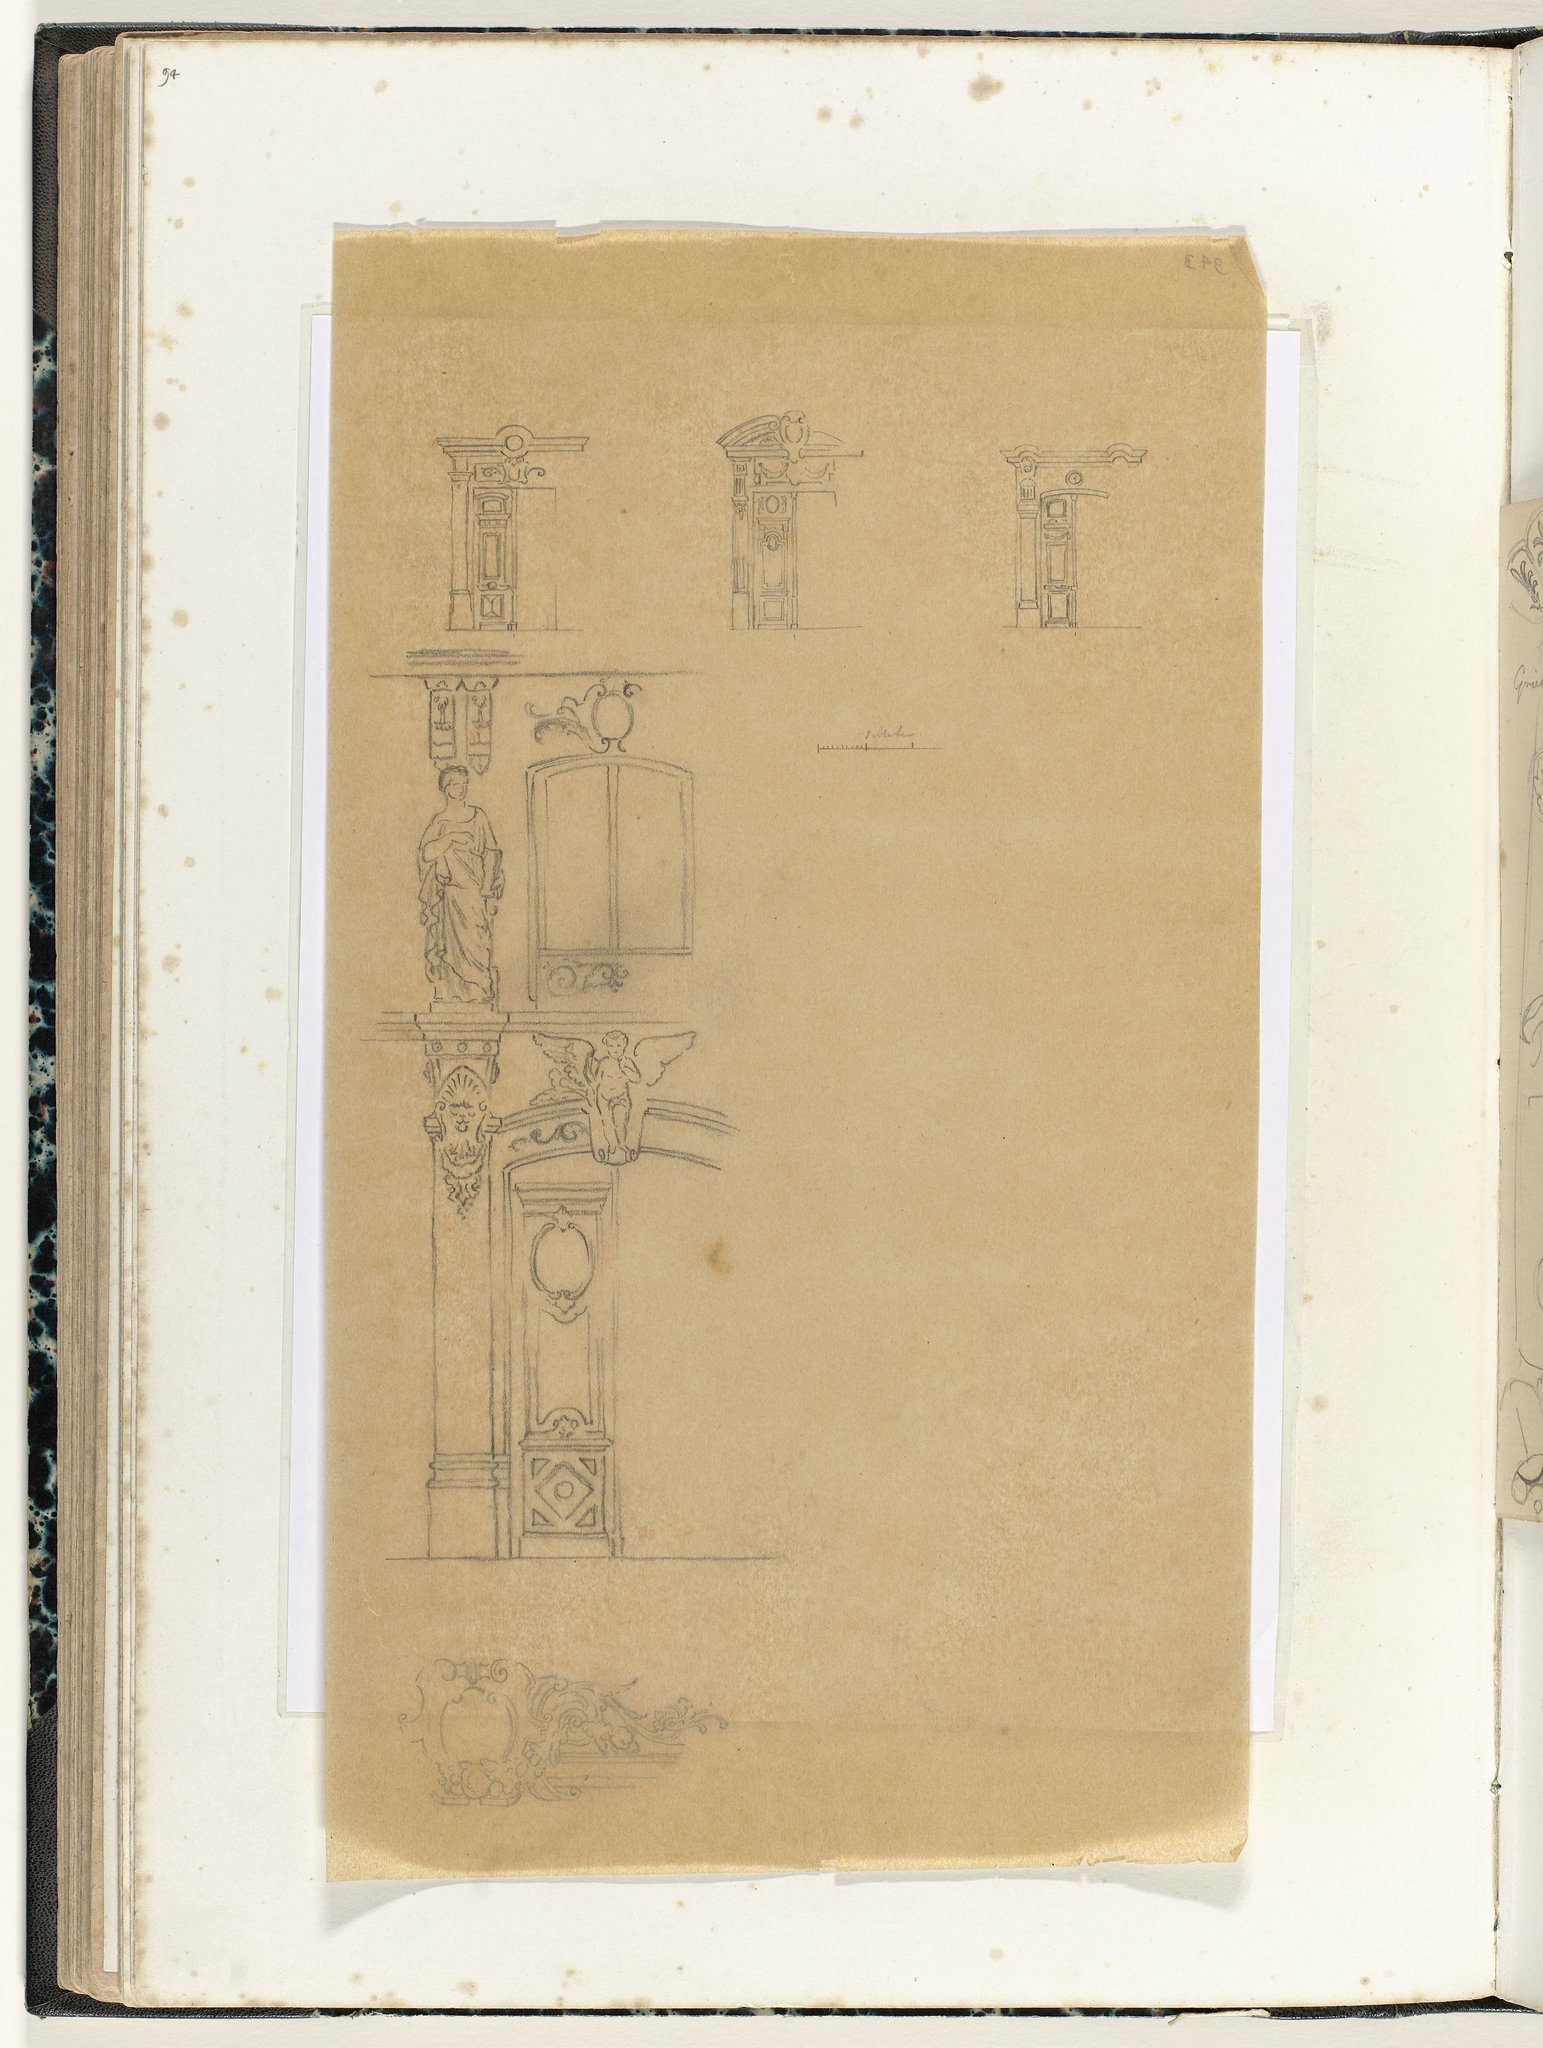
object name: drawing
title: Vier portieken en een detail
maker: Anonymous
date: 1866-1900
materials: pencil, paper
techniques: drawing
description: Bovenaan zijn drie kleine portieken afgebeeld, rechtsonder een groot met een detail. Alle portieken zijn gedeeltelijk weergegeven.